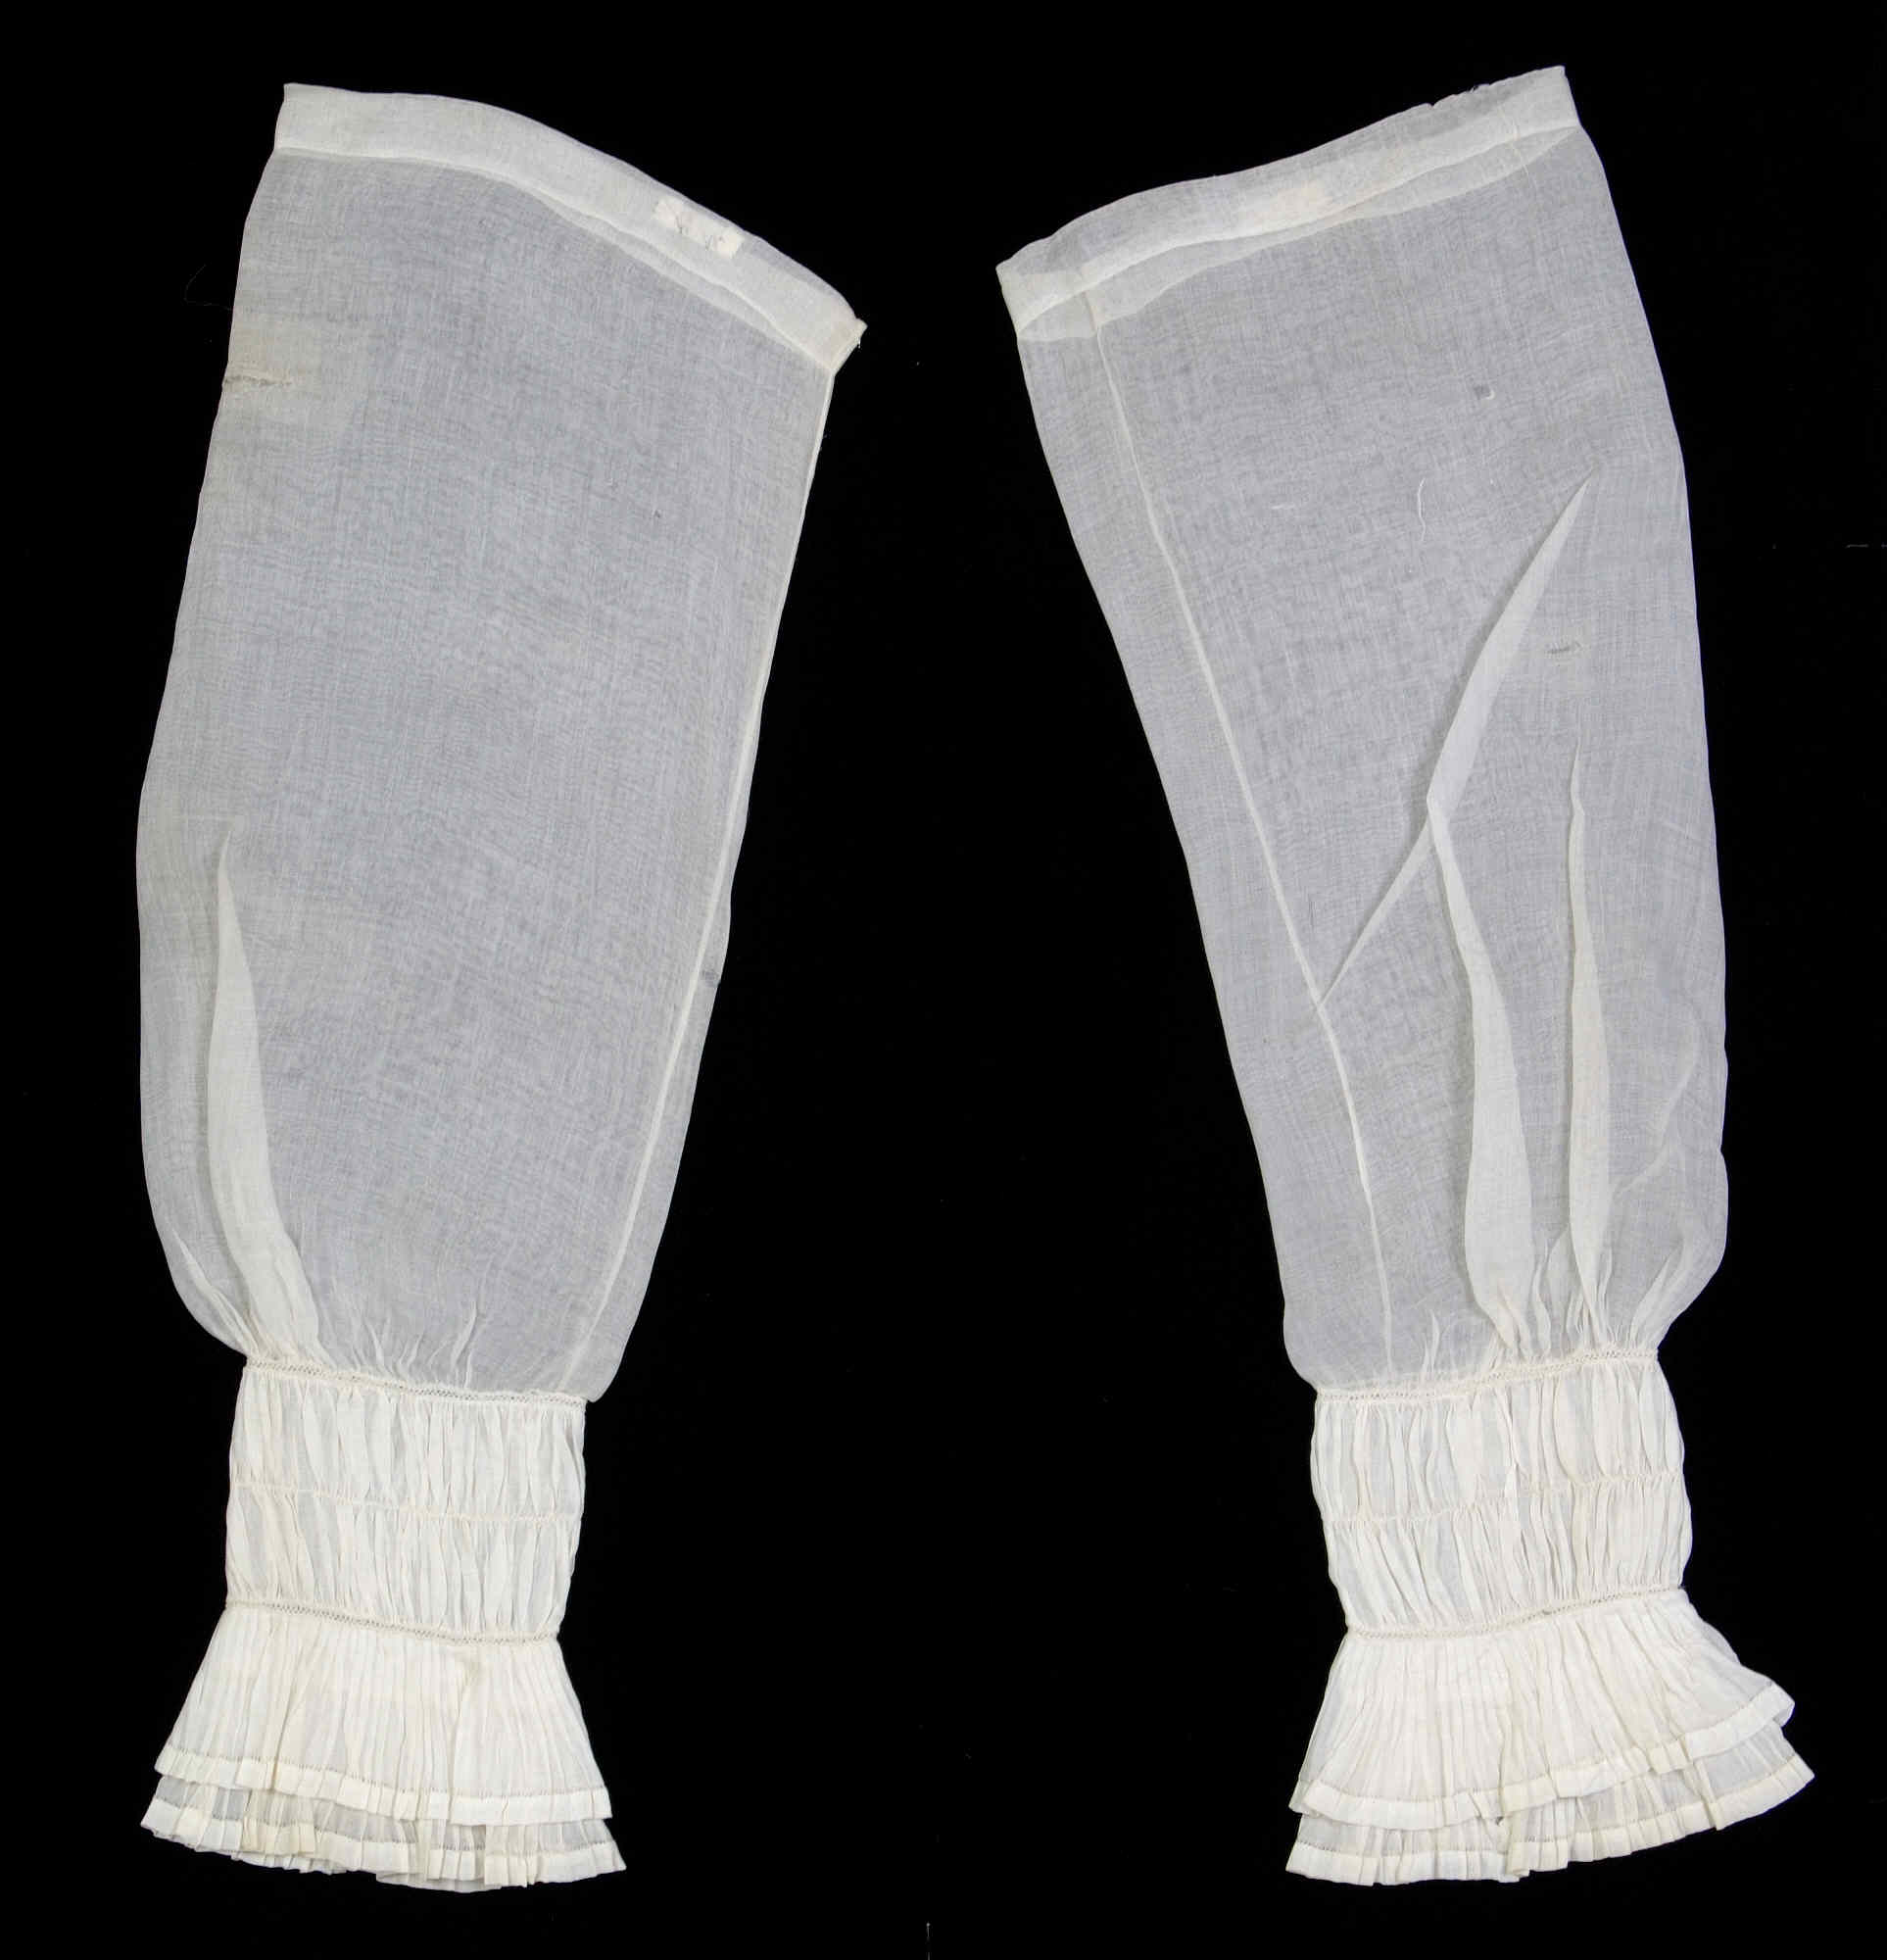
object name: undersleeves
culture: french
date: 1825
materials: cotton